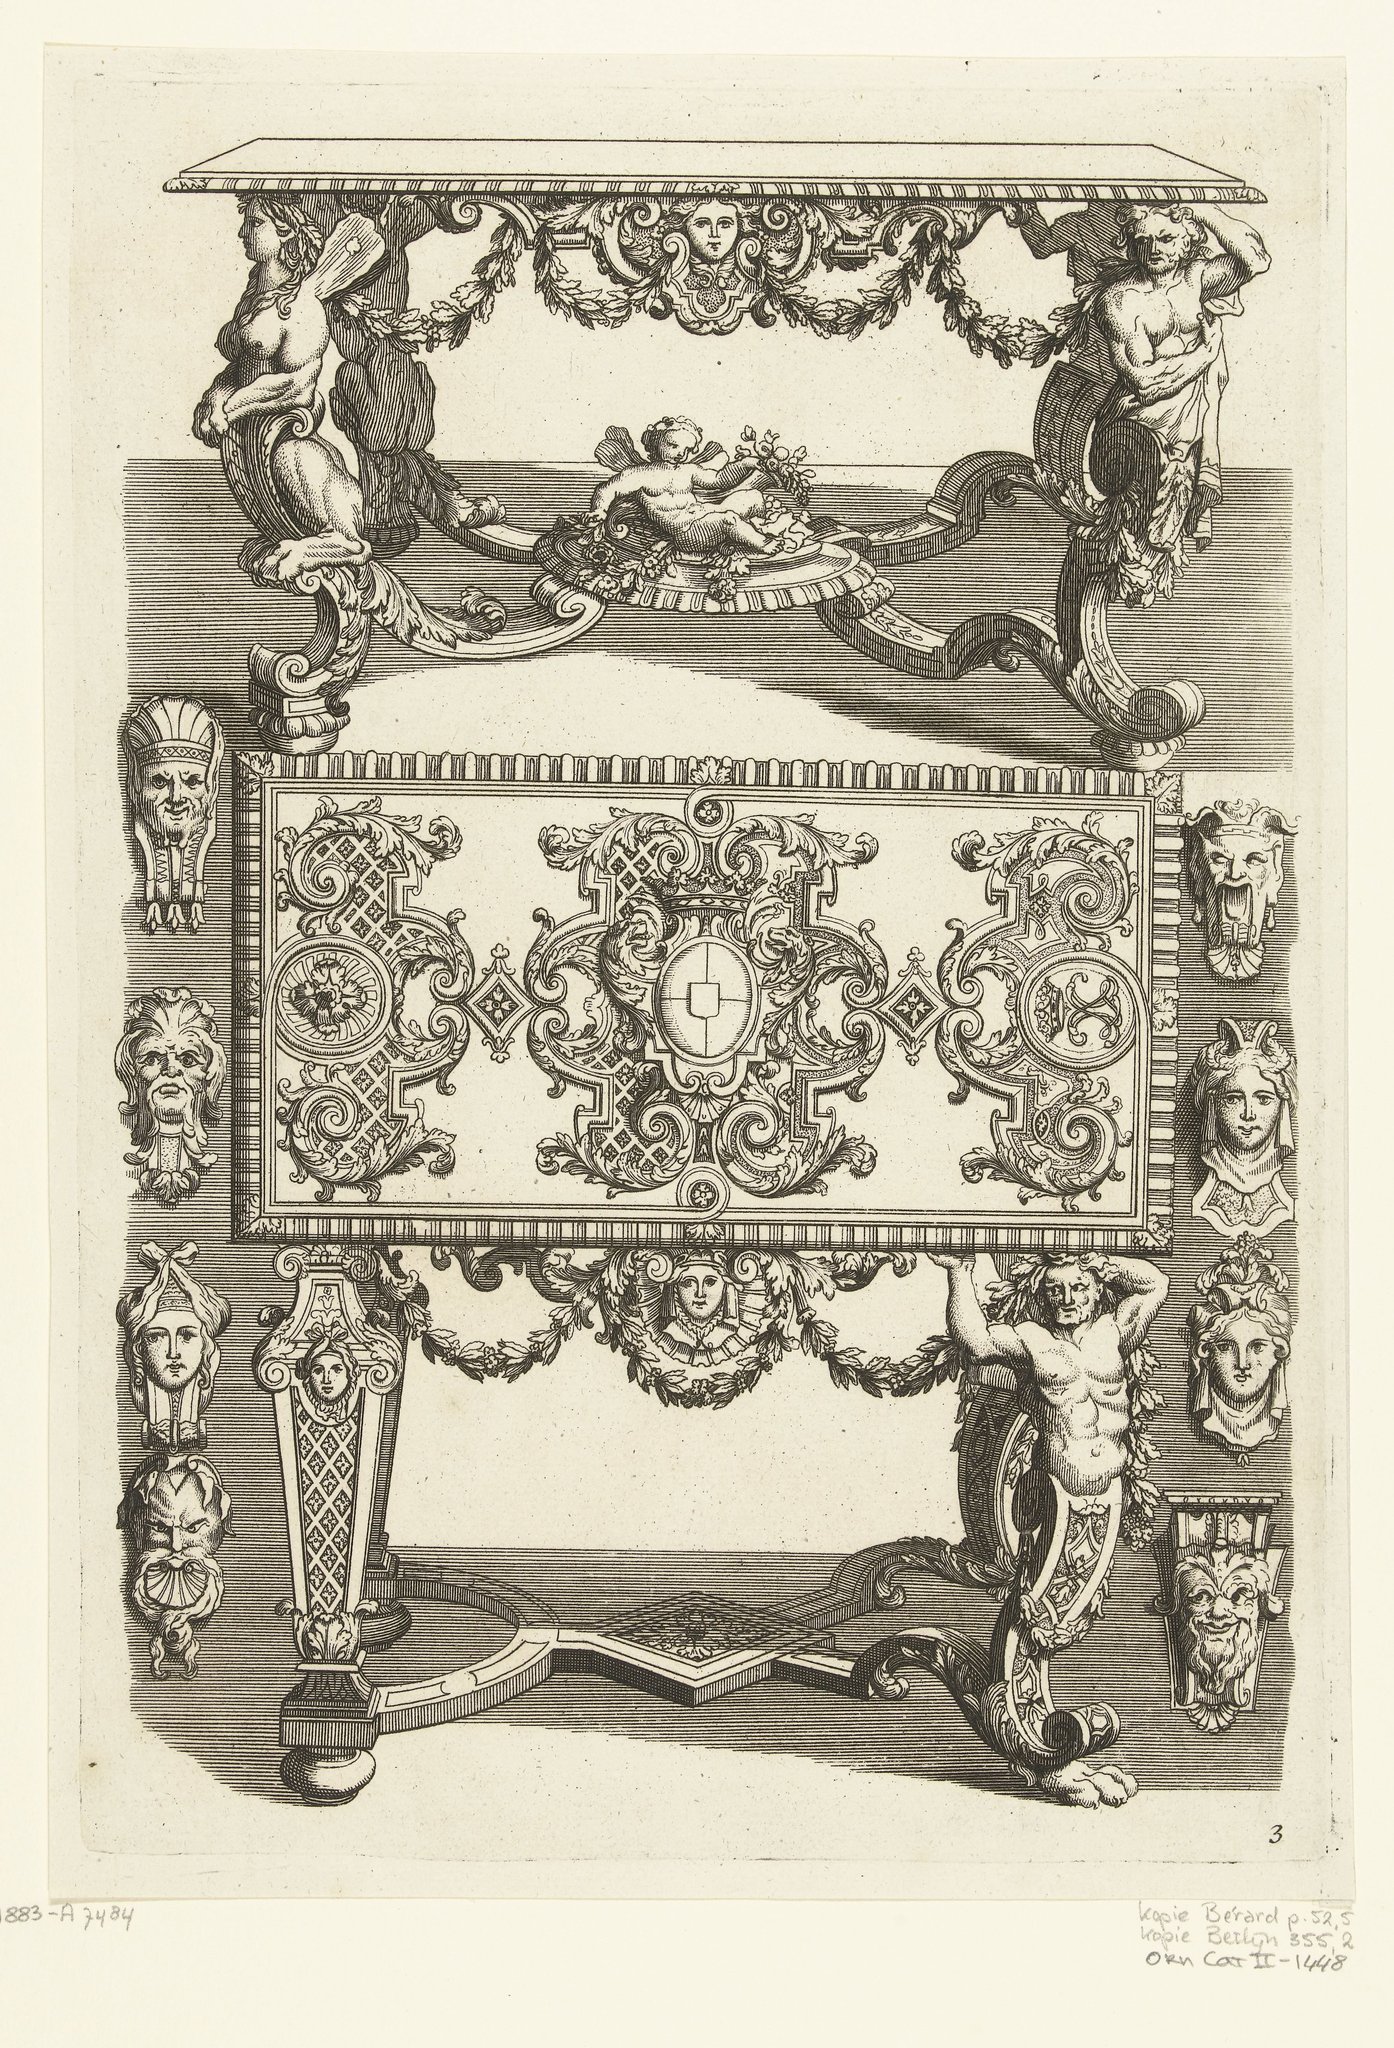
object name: print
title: Twee tafels met varianten voor de ondersteuning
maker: Anonymous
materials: paper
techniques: etching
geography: netherlands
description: De bovenste tafel is in perspectief getekend, bij de onderste is het tafelblad rechtop afgebeeld. Aan beide kanten zijn vier maskers weergegeven.